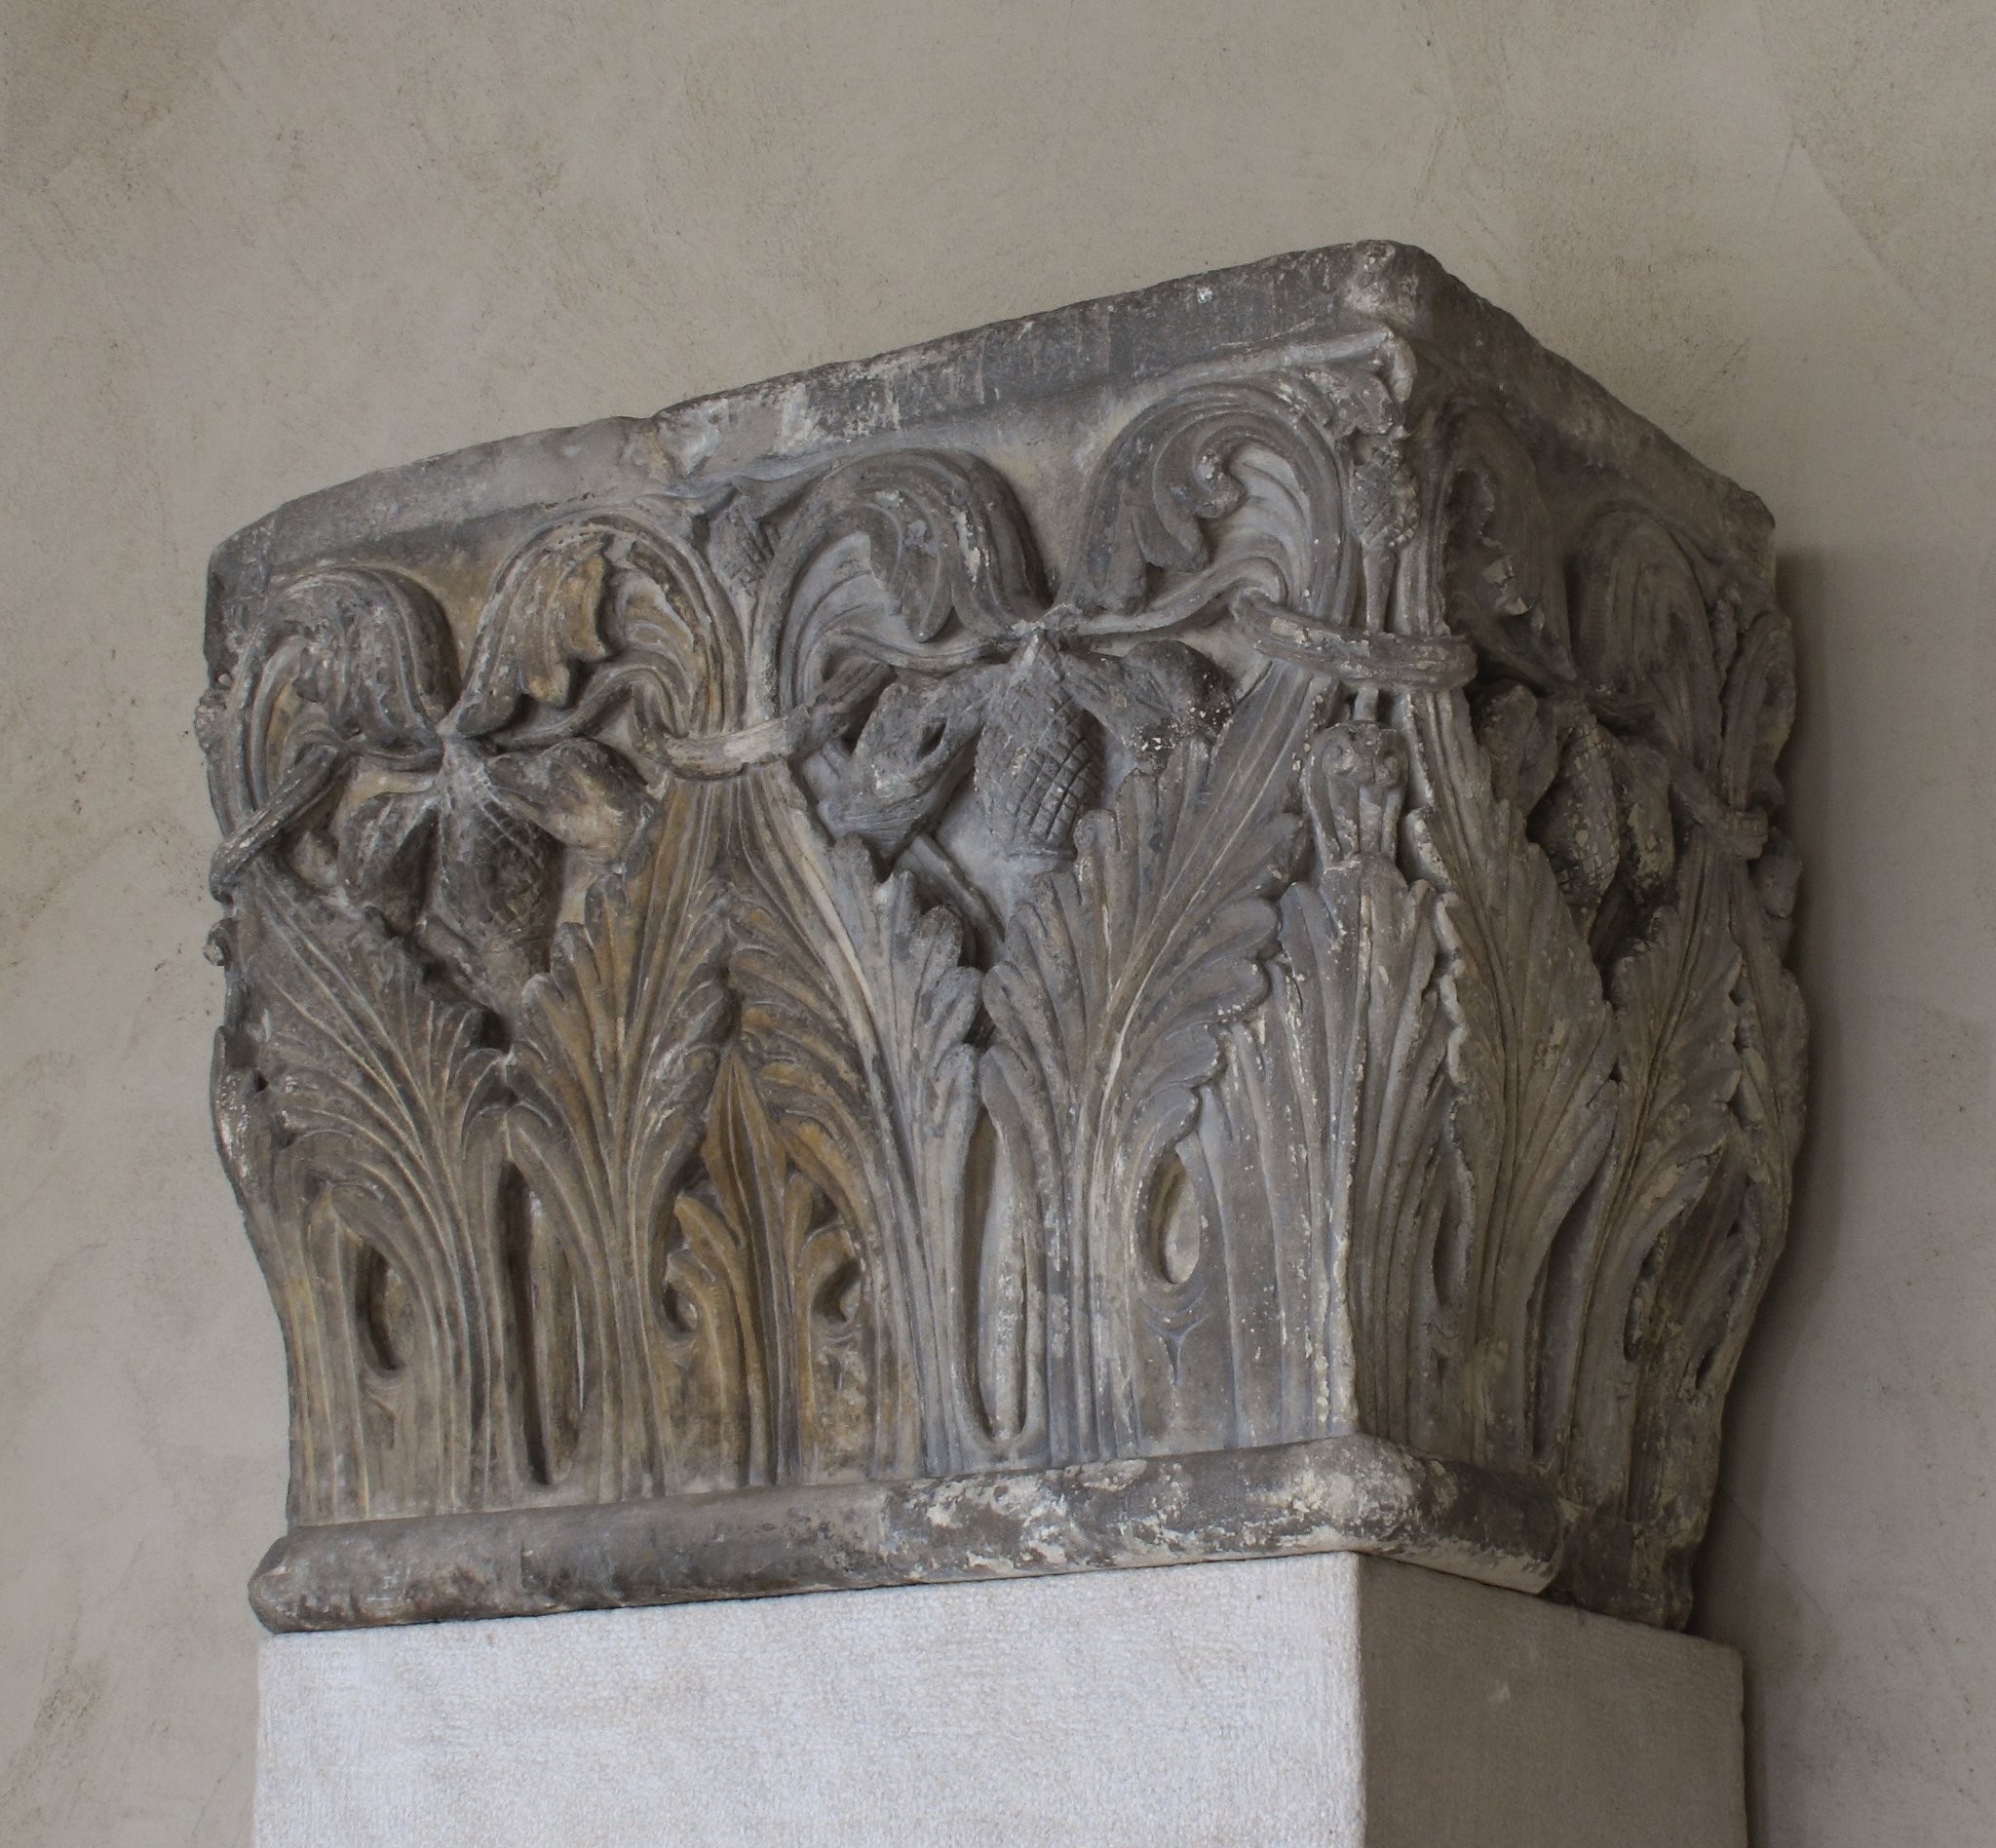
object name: capital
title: Impost Block with Acanthus Decoration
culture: french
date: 1101-1200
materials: limestone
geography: france